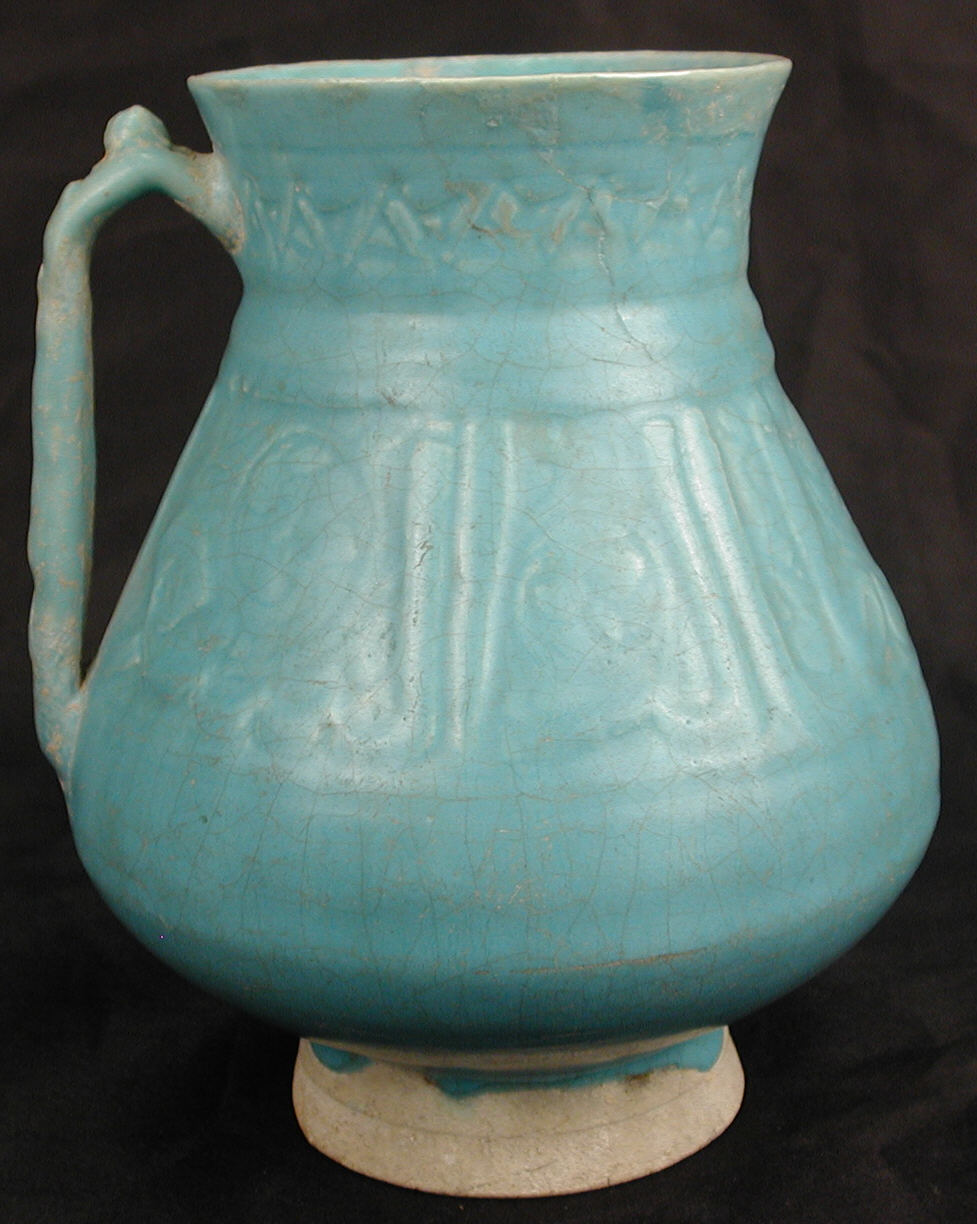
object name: ewer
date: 1101-1200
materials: stonepaste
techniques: glazing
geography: iran